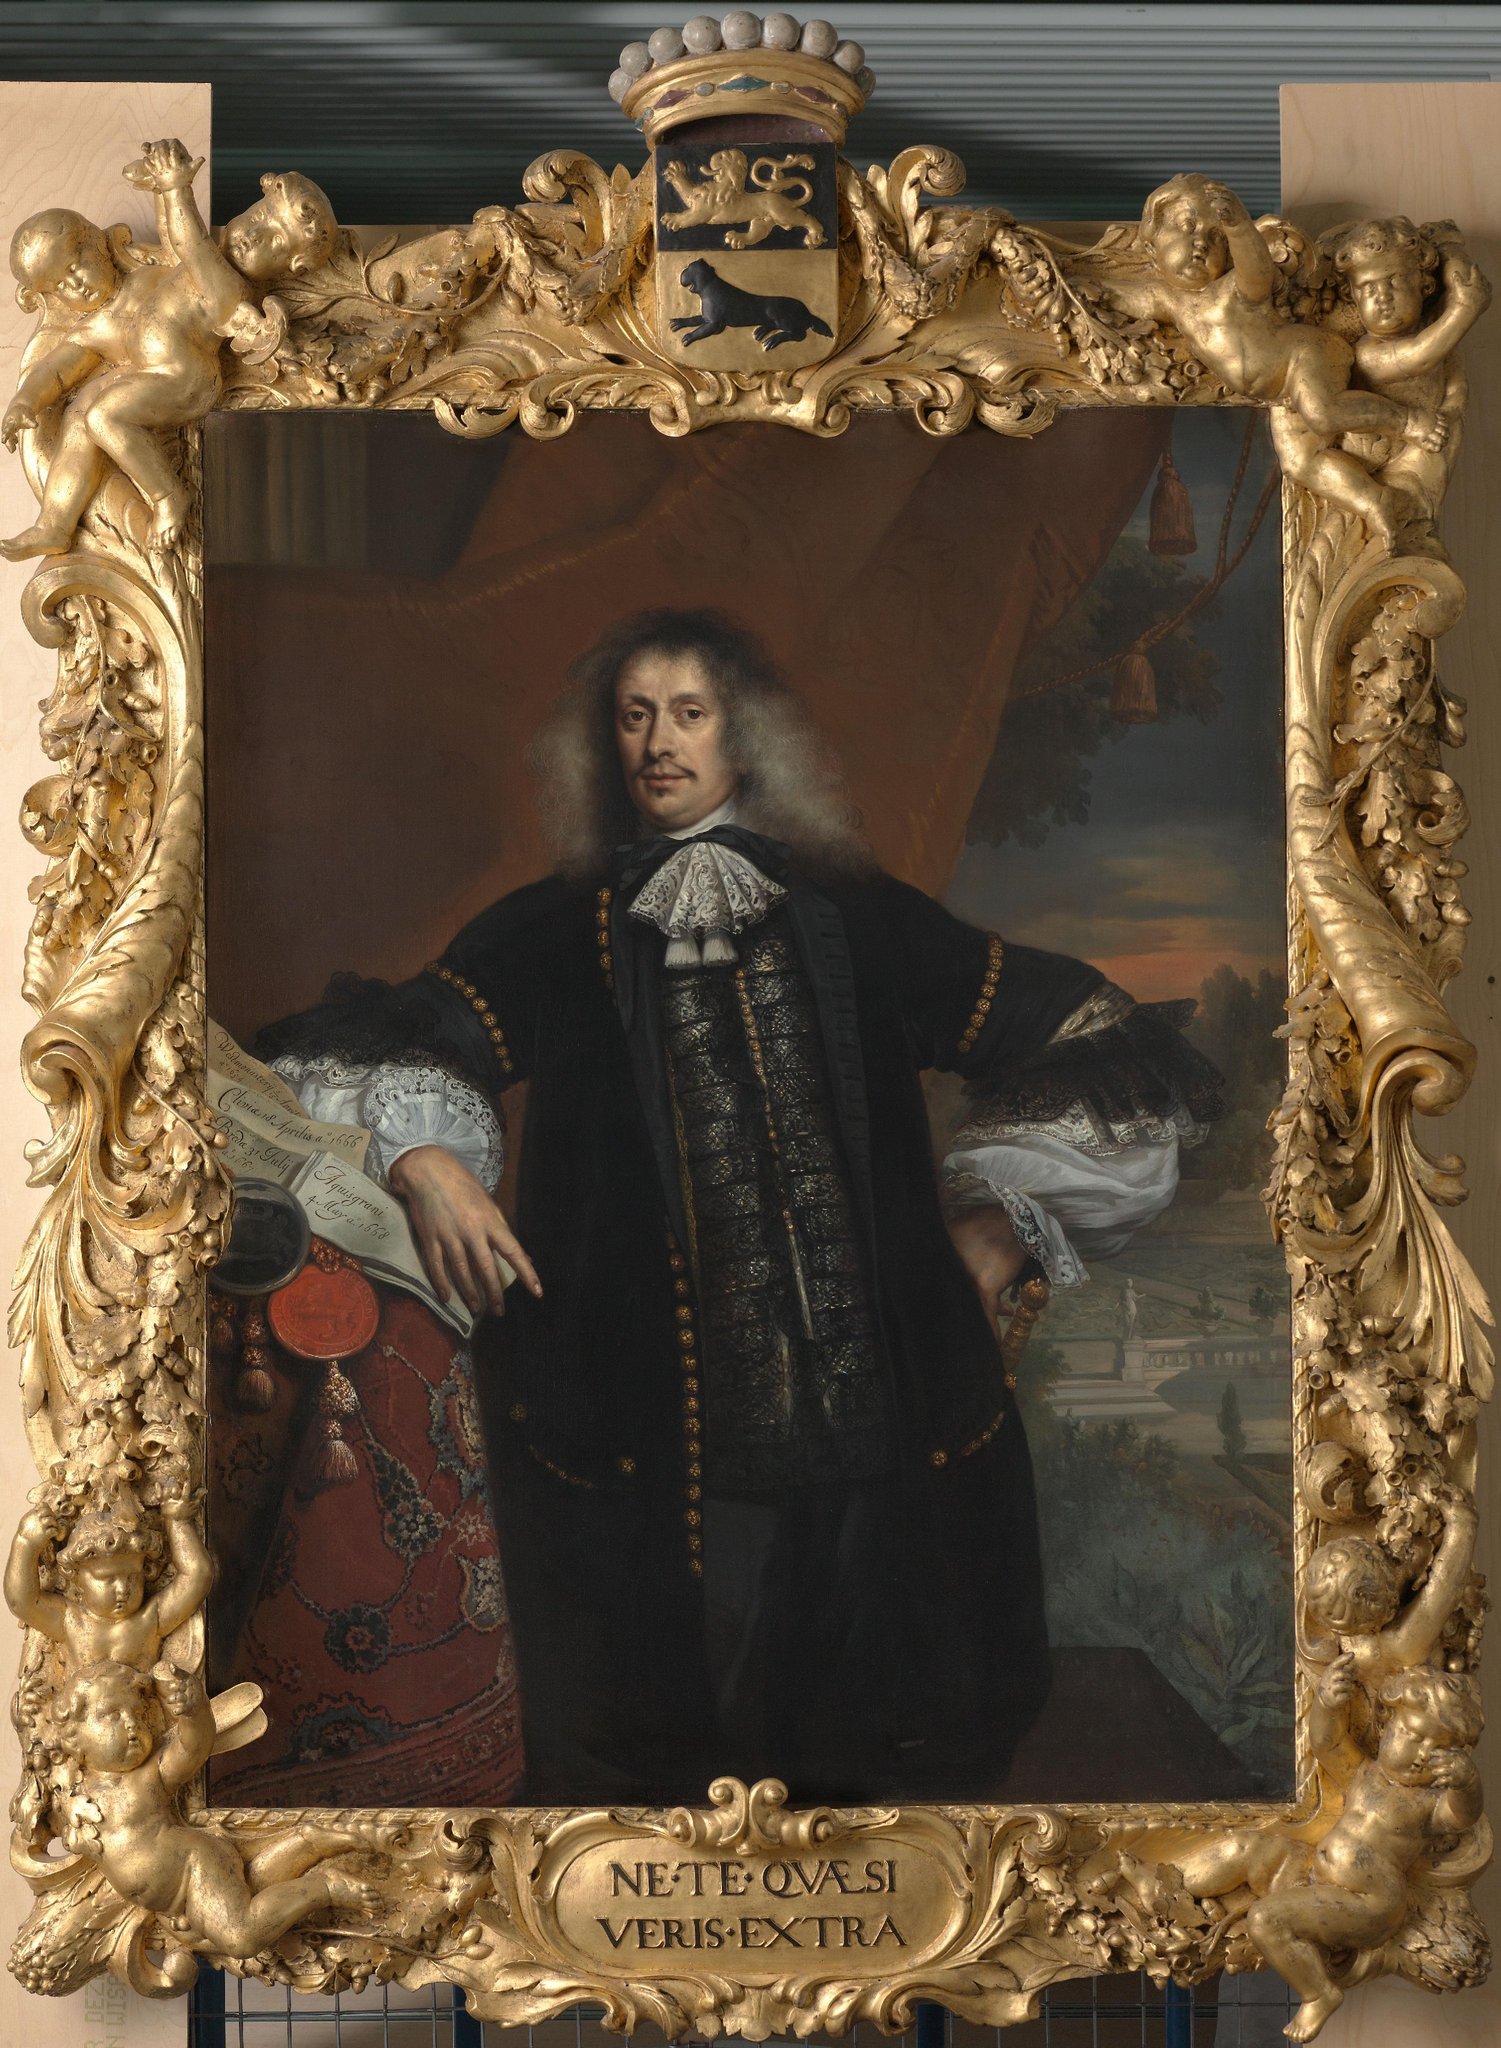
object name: painting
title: Hieronymus van Beverningk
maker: jan de baen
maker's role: draughtsman, print maker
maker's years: 1633-1702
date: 1670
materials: canvas, oil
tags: leiden, historical persons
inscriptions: signature and date: ‘J. de Baen Fecit 1670’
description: As envoy of the States-General of the Netherlands, Hieronymus van Beverningk took part in many diplomatic negotiations, including the Peace of Aachen in May 1668. The state documents on the table mention the city’s Latin name Aquisgrani. The picture frame emphasizes the stateliness of the sitter and corresponds with that of his wife, Johanna le Gillon. In the cartouche at the bottom is his motto, in translation: ‘Seek thyself, not outside thyself.’